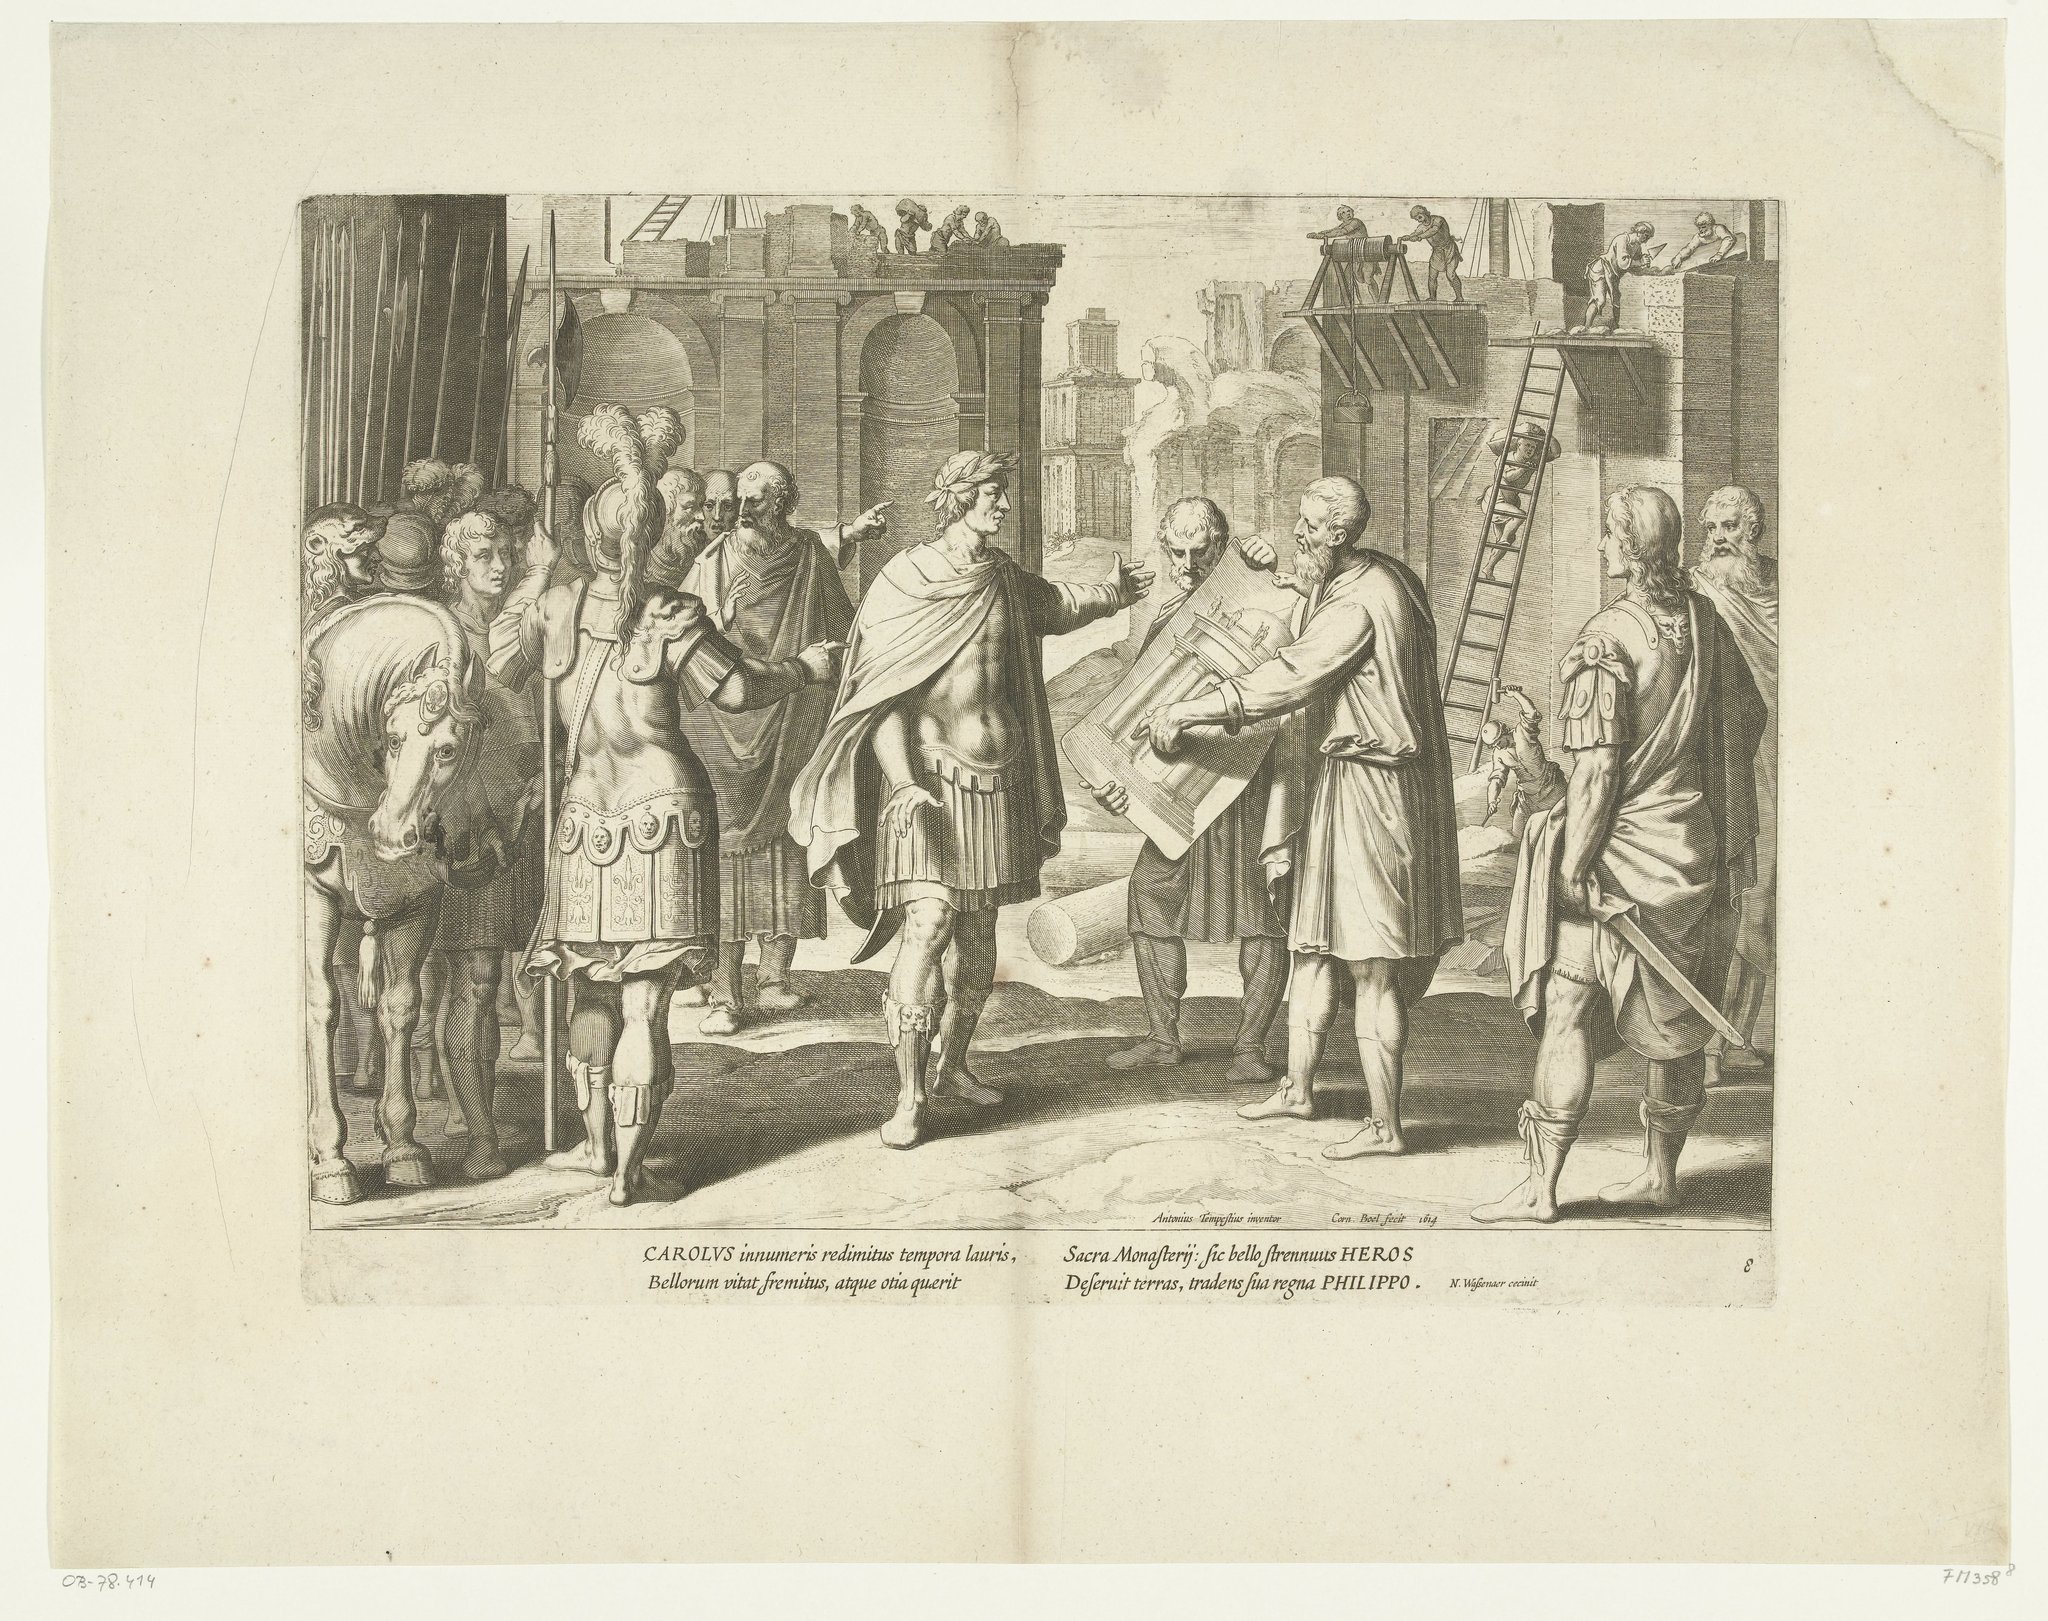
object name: print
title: Keizer Karel V laat een klooster bouwen, 1555, nr. 8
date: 1614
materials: paper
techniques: engraving, etching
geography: northern netherlands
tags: ghent, charles v (holy roman emperor and king of spain), building-site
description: Karel V in overleg met de architecten van het klooster dat hij laat bouwen. Op de achtergrond bouwwerkzaamheden, 1555. Met onderschrift van vier regels in het Latijn.